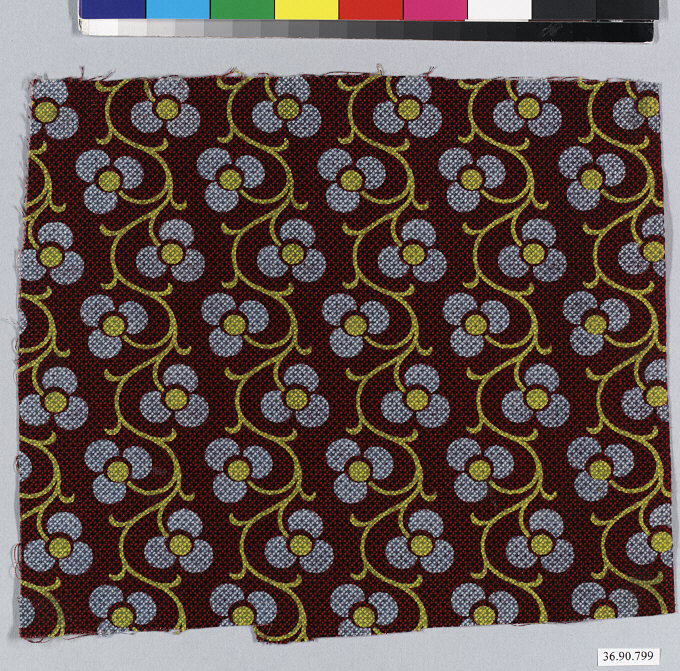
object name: piece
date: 1867-1900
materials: cotton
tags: flowers